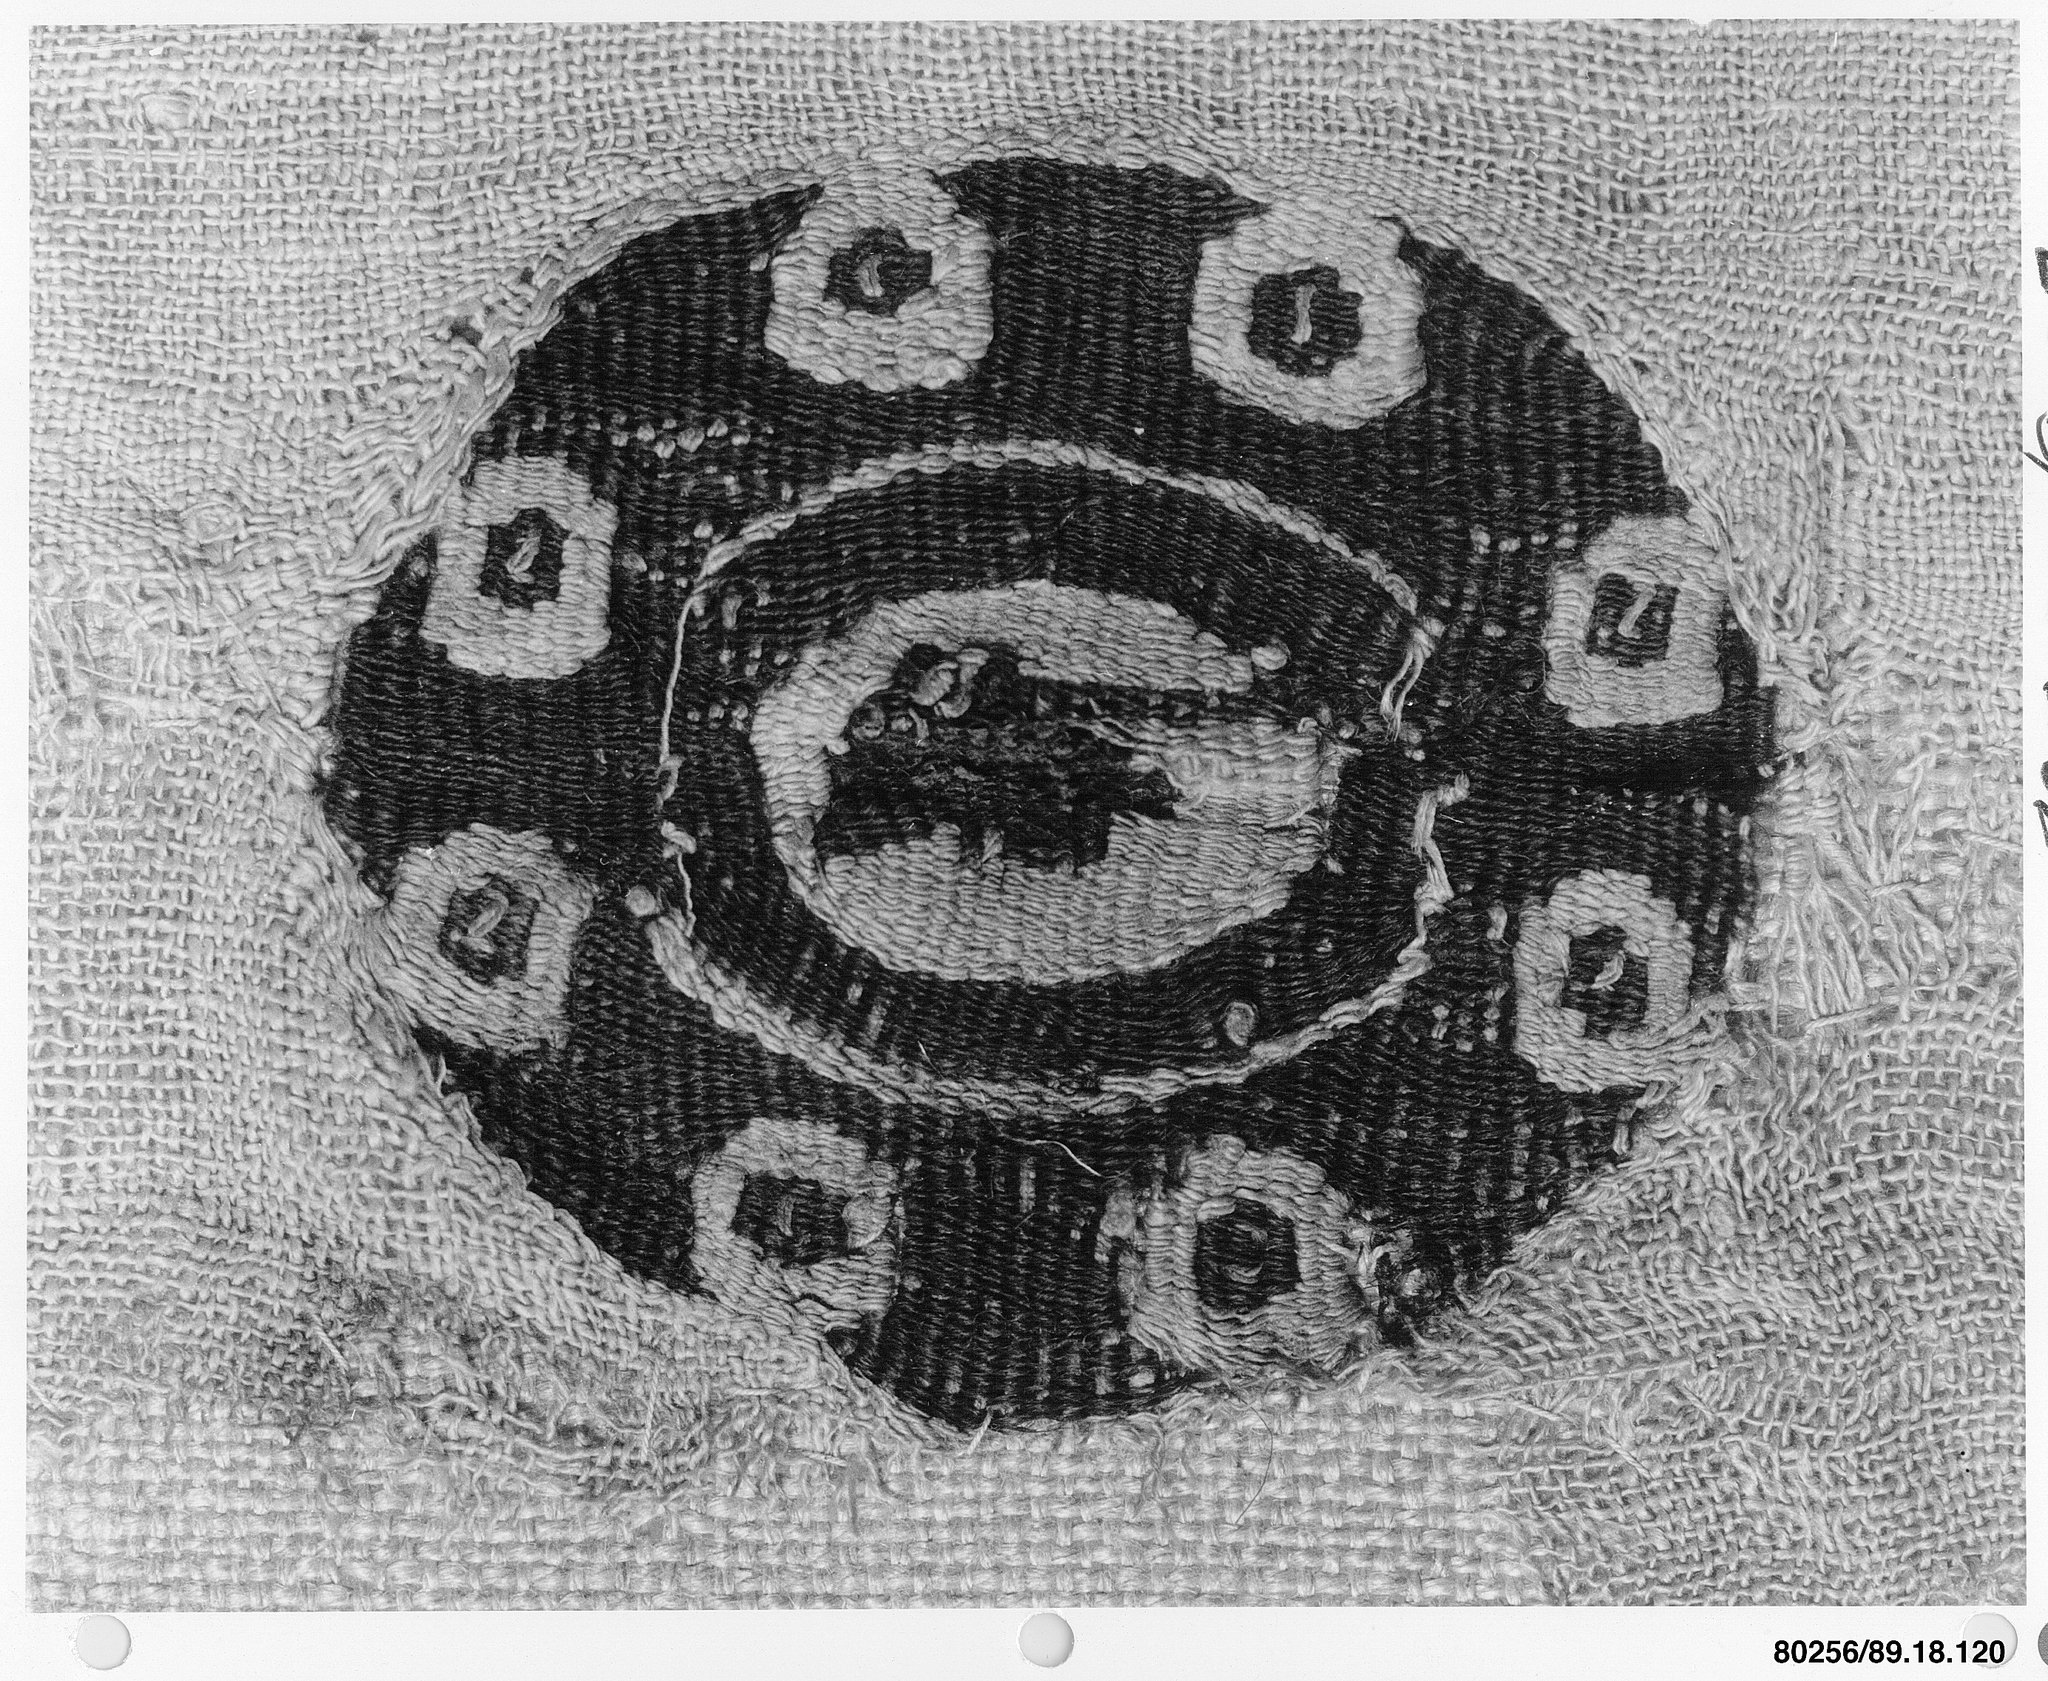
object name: textile fragment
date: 301-400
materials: linen, wool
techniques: weave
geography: egypt